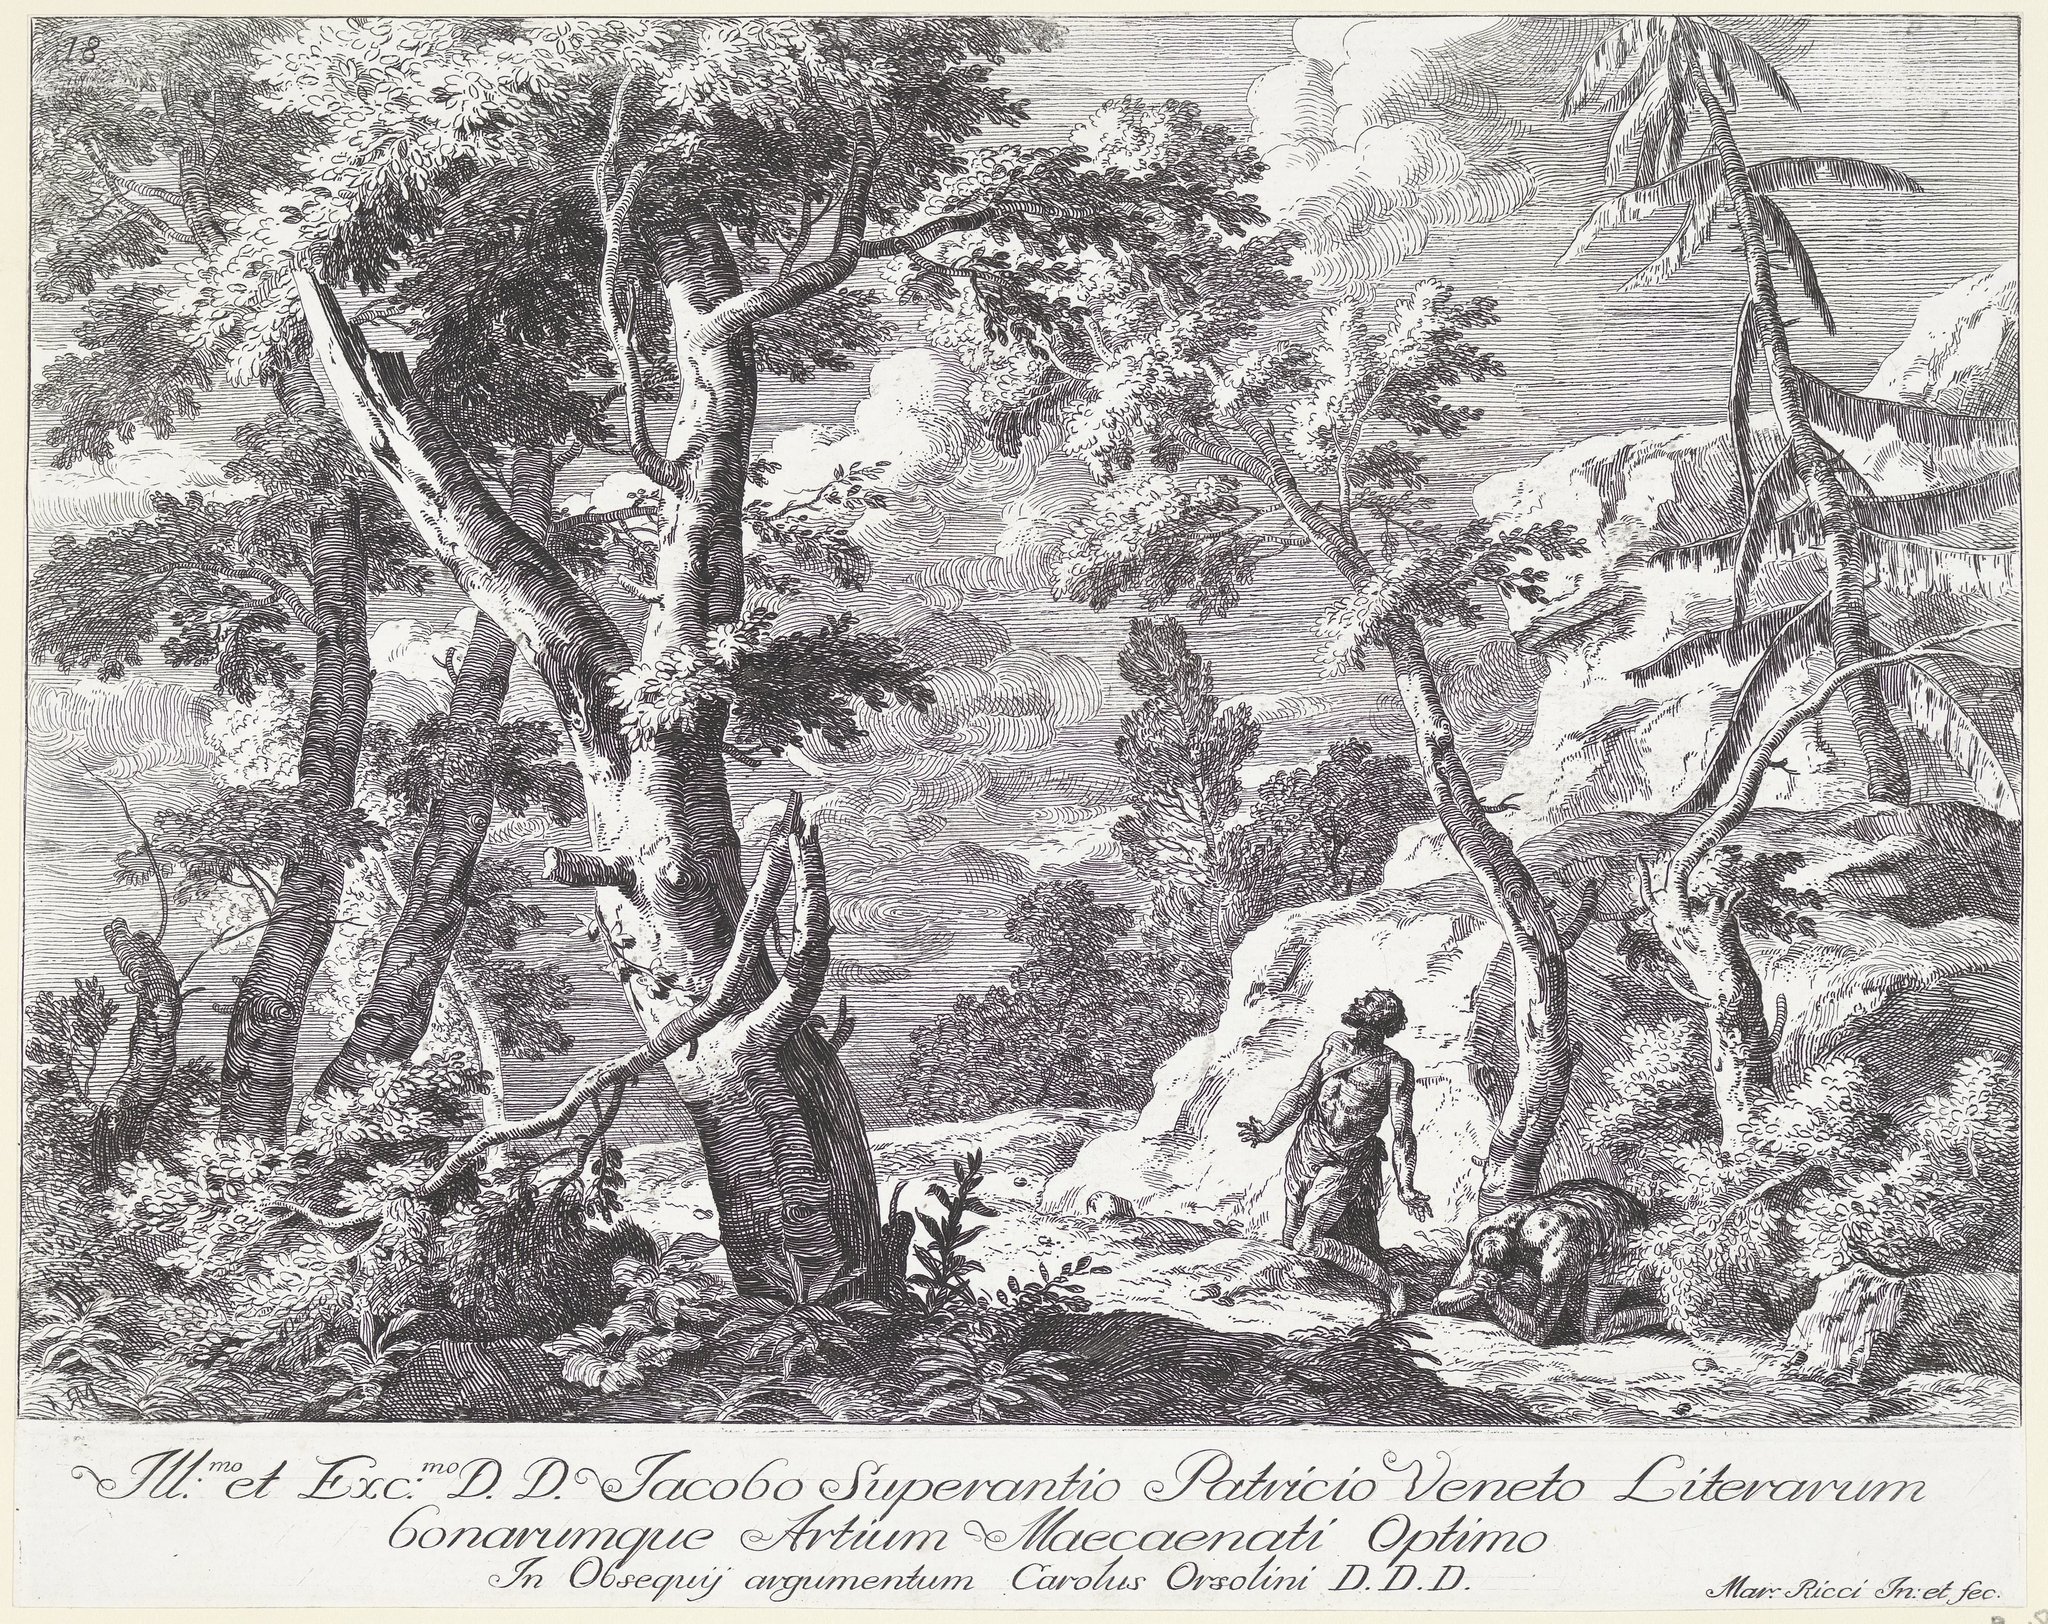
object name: print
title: Landschap met twee boetvaardige mannen in gebed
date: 1730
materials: paper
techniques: etching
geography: italy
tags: renouncing the world ~ penitent sinner, landscapes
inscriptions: collector's mark: Lugt 2228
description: Deze prent maakt deel uit van een reeks van twintig prenten door Marco Ricci. De prenten zijn na de dood van Ricci in 1730 gebundeld door Carlo Orsolini en voorzien van een titelprent.